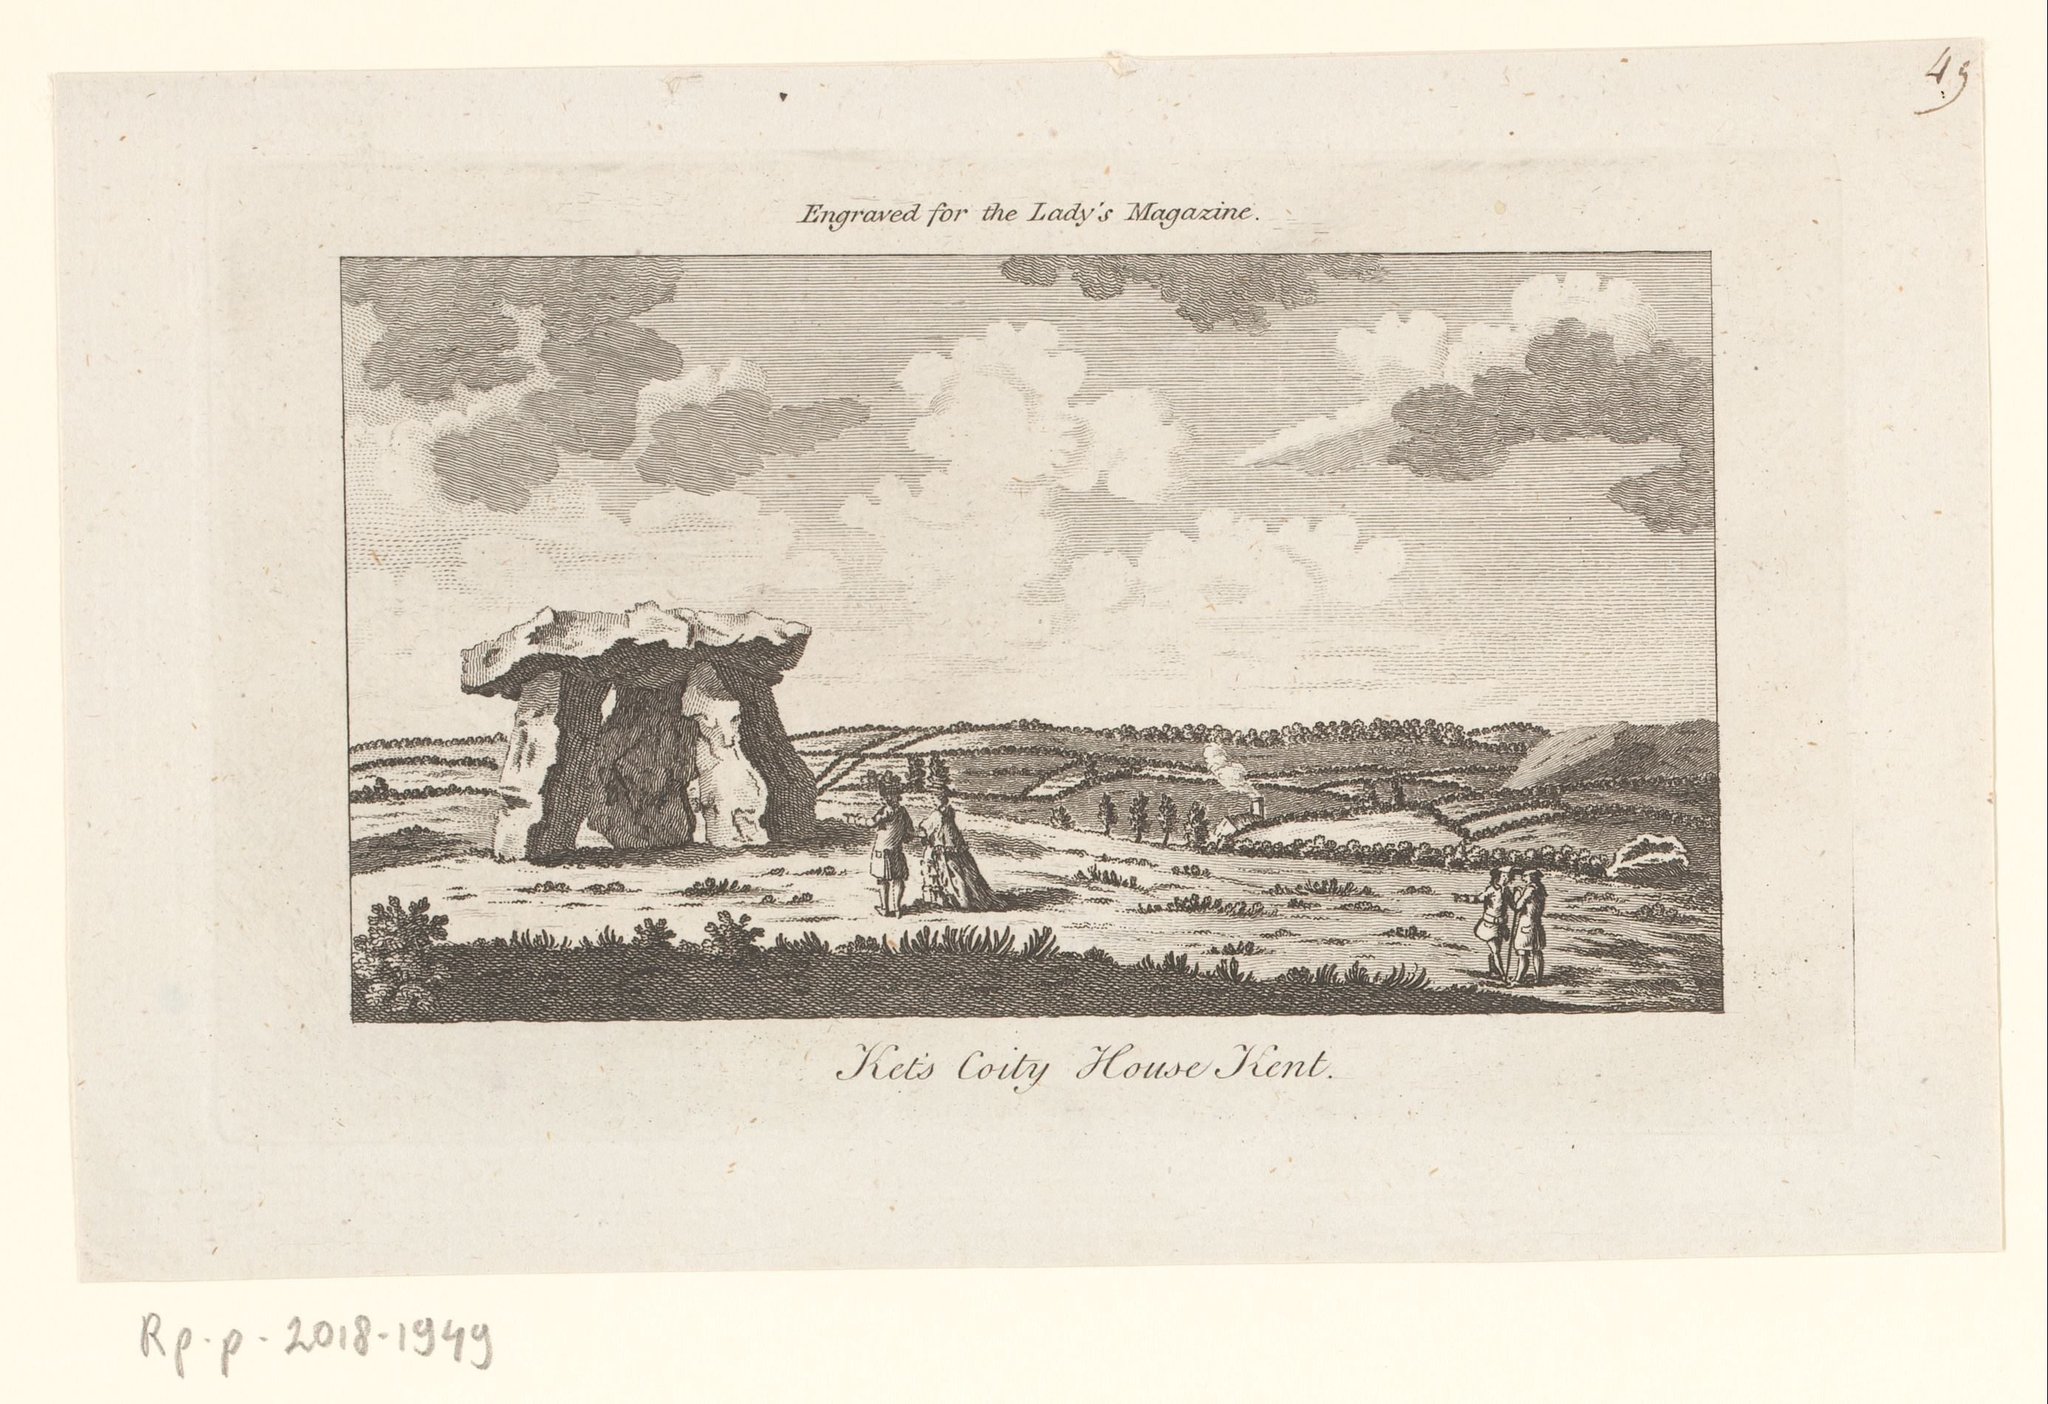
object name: print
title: Kets coity House Kent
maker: Anonymous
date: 1791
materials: paper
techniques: etching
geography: london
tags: grave, tomb and other grave-forms and grave-markers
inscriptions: collector's mark: Lugt 2228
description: Prent gebruikt in: The Ladies Magazine or entertaining companion for the fair sex (...). Londen: G.G.J & J. Robinson, 1791.